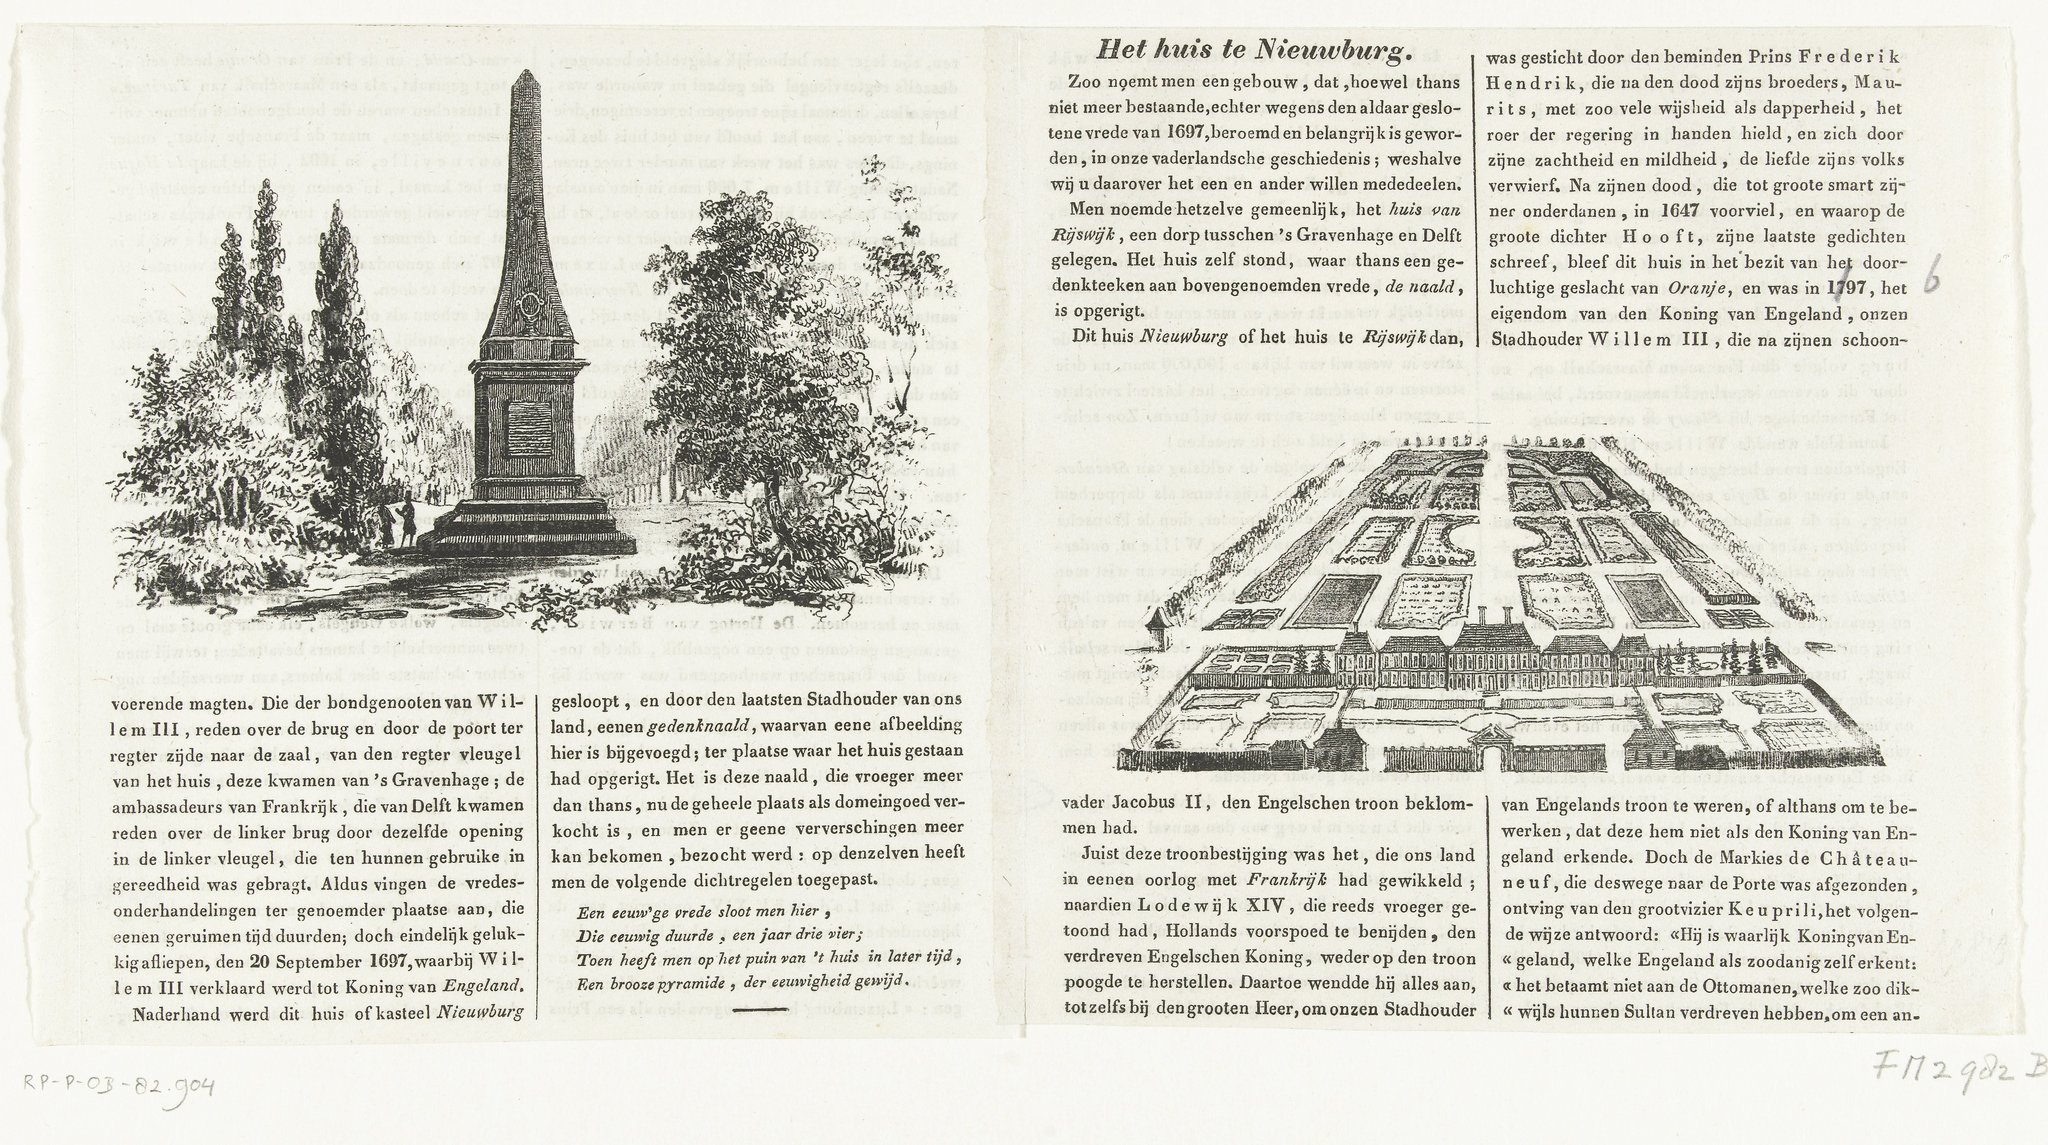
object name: historical object representation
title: Gedenknaald voor de Vrede van Rijswijk met gezicht op het Huis ter Nieuburch 1697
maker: Anonymous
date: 1800-1899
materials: paper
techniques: lithograph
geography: netherlands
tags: palace, monument, statue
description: Gedenknaald in het Rijswijkse bos opgericht in 1792 op de plaats waar vroeger het Huis ter Nieuburch heeft gestaan, waar de Vrede van Rijswijk is gesloten op 20 september 1697 tussen Frankrijk en de geallieerden. Met een gezicht op het paleis in vogelvluchtperspectief. Deel van een blad genomen uit een tijdschrift.